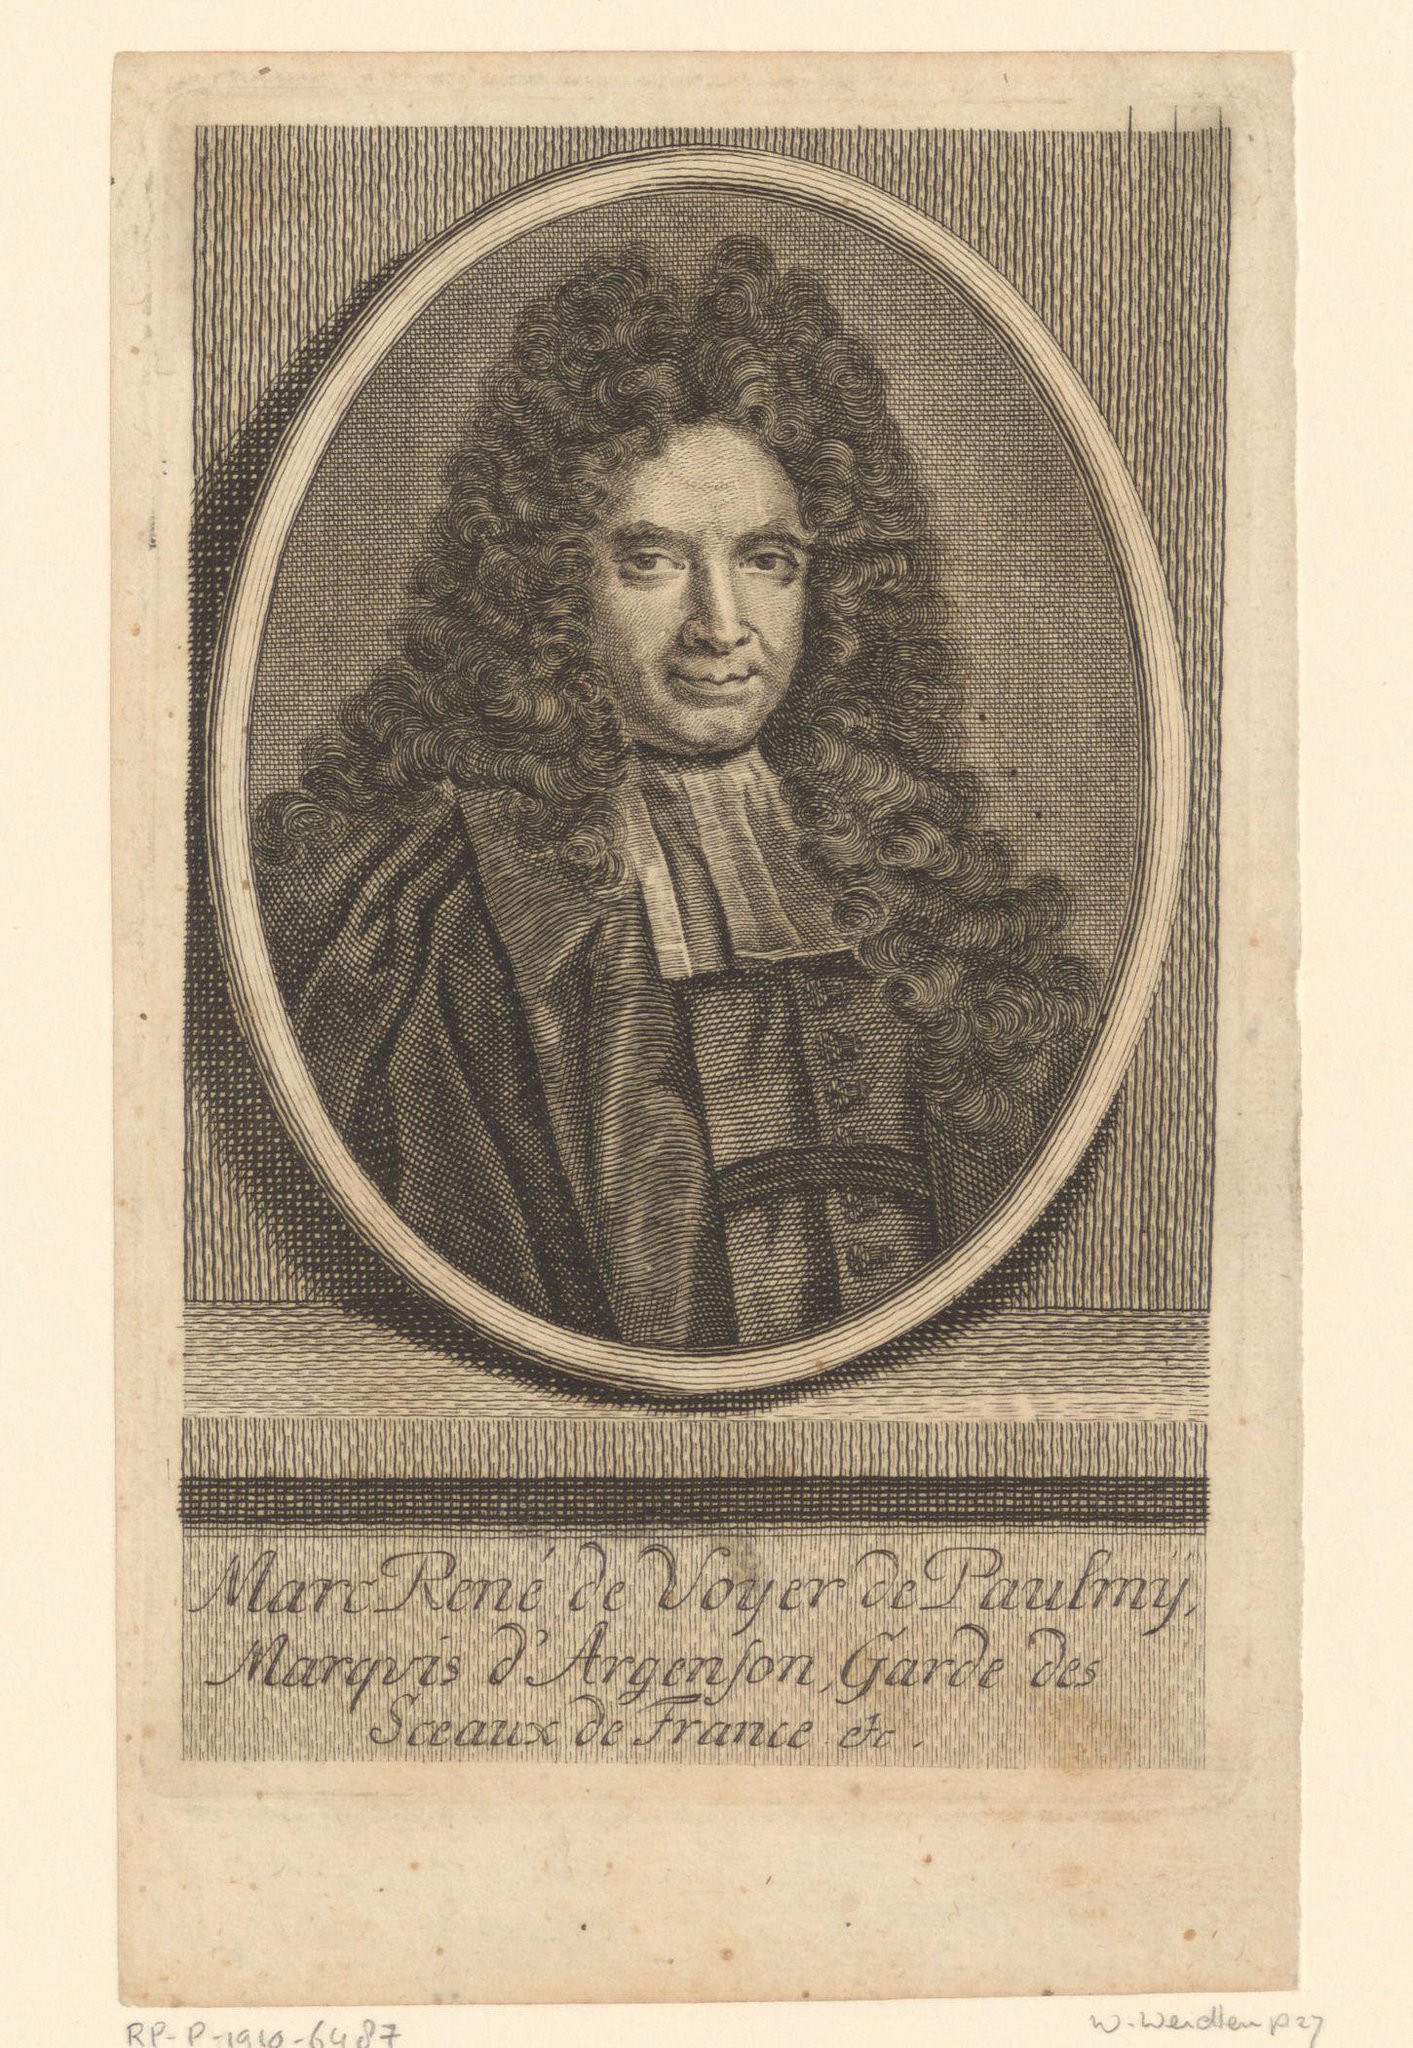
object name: print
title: Portret van Marc-René de Paulmy, markies van Argenson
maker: martin bernigeroth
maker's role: print maker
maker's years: 1670-1733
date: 1718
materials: paper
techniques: engraving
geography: leipzig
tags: venice, paris, marc-rené de voyer de paulmy d’argenson markies d' voyer, historical persons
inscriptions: collector's mark: Lugt 2228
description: Prent ook gebruikt in: Die Europäische Fama, Welche den gegenwärtigen Zustand der vornehmsten Höfe entdecket. dl. 213. Leipzig: Gleditsch, 1718.